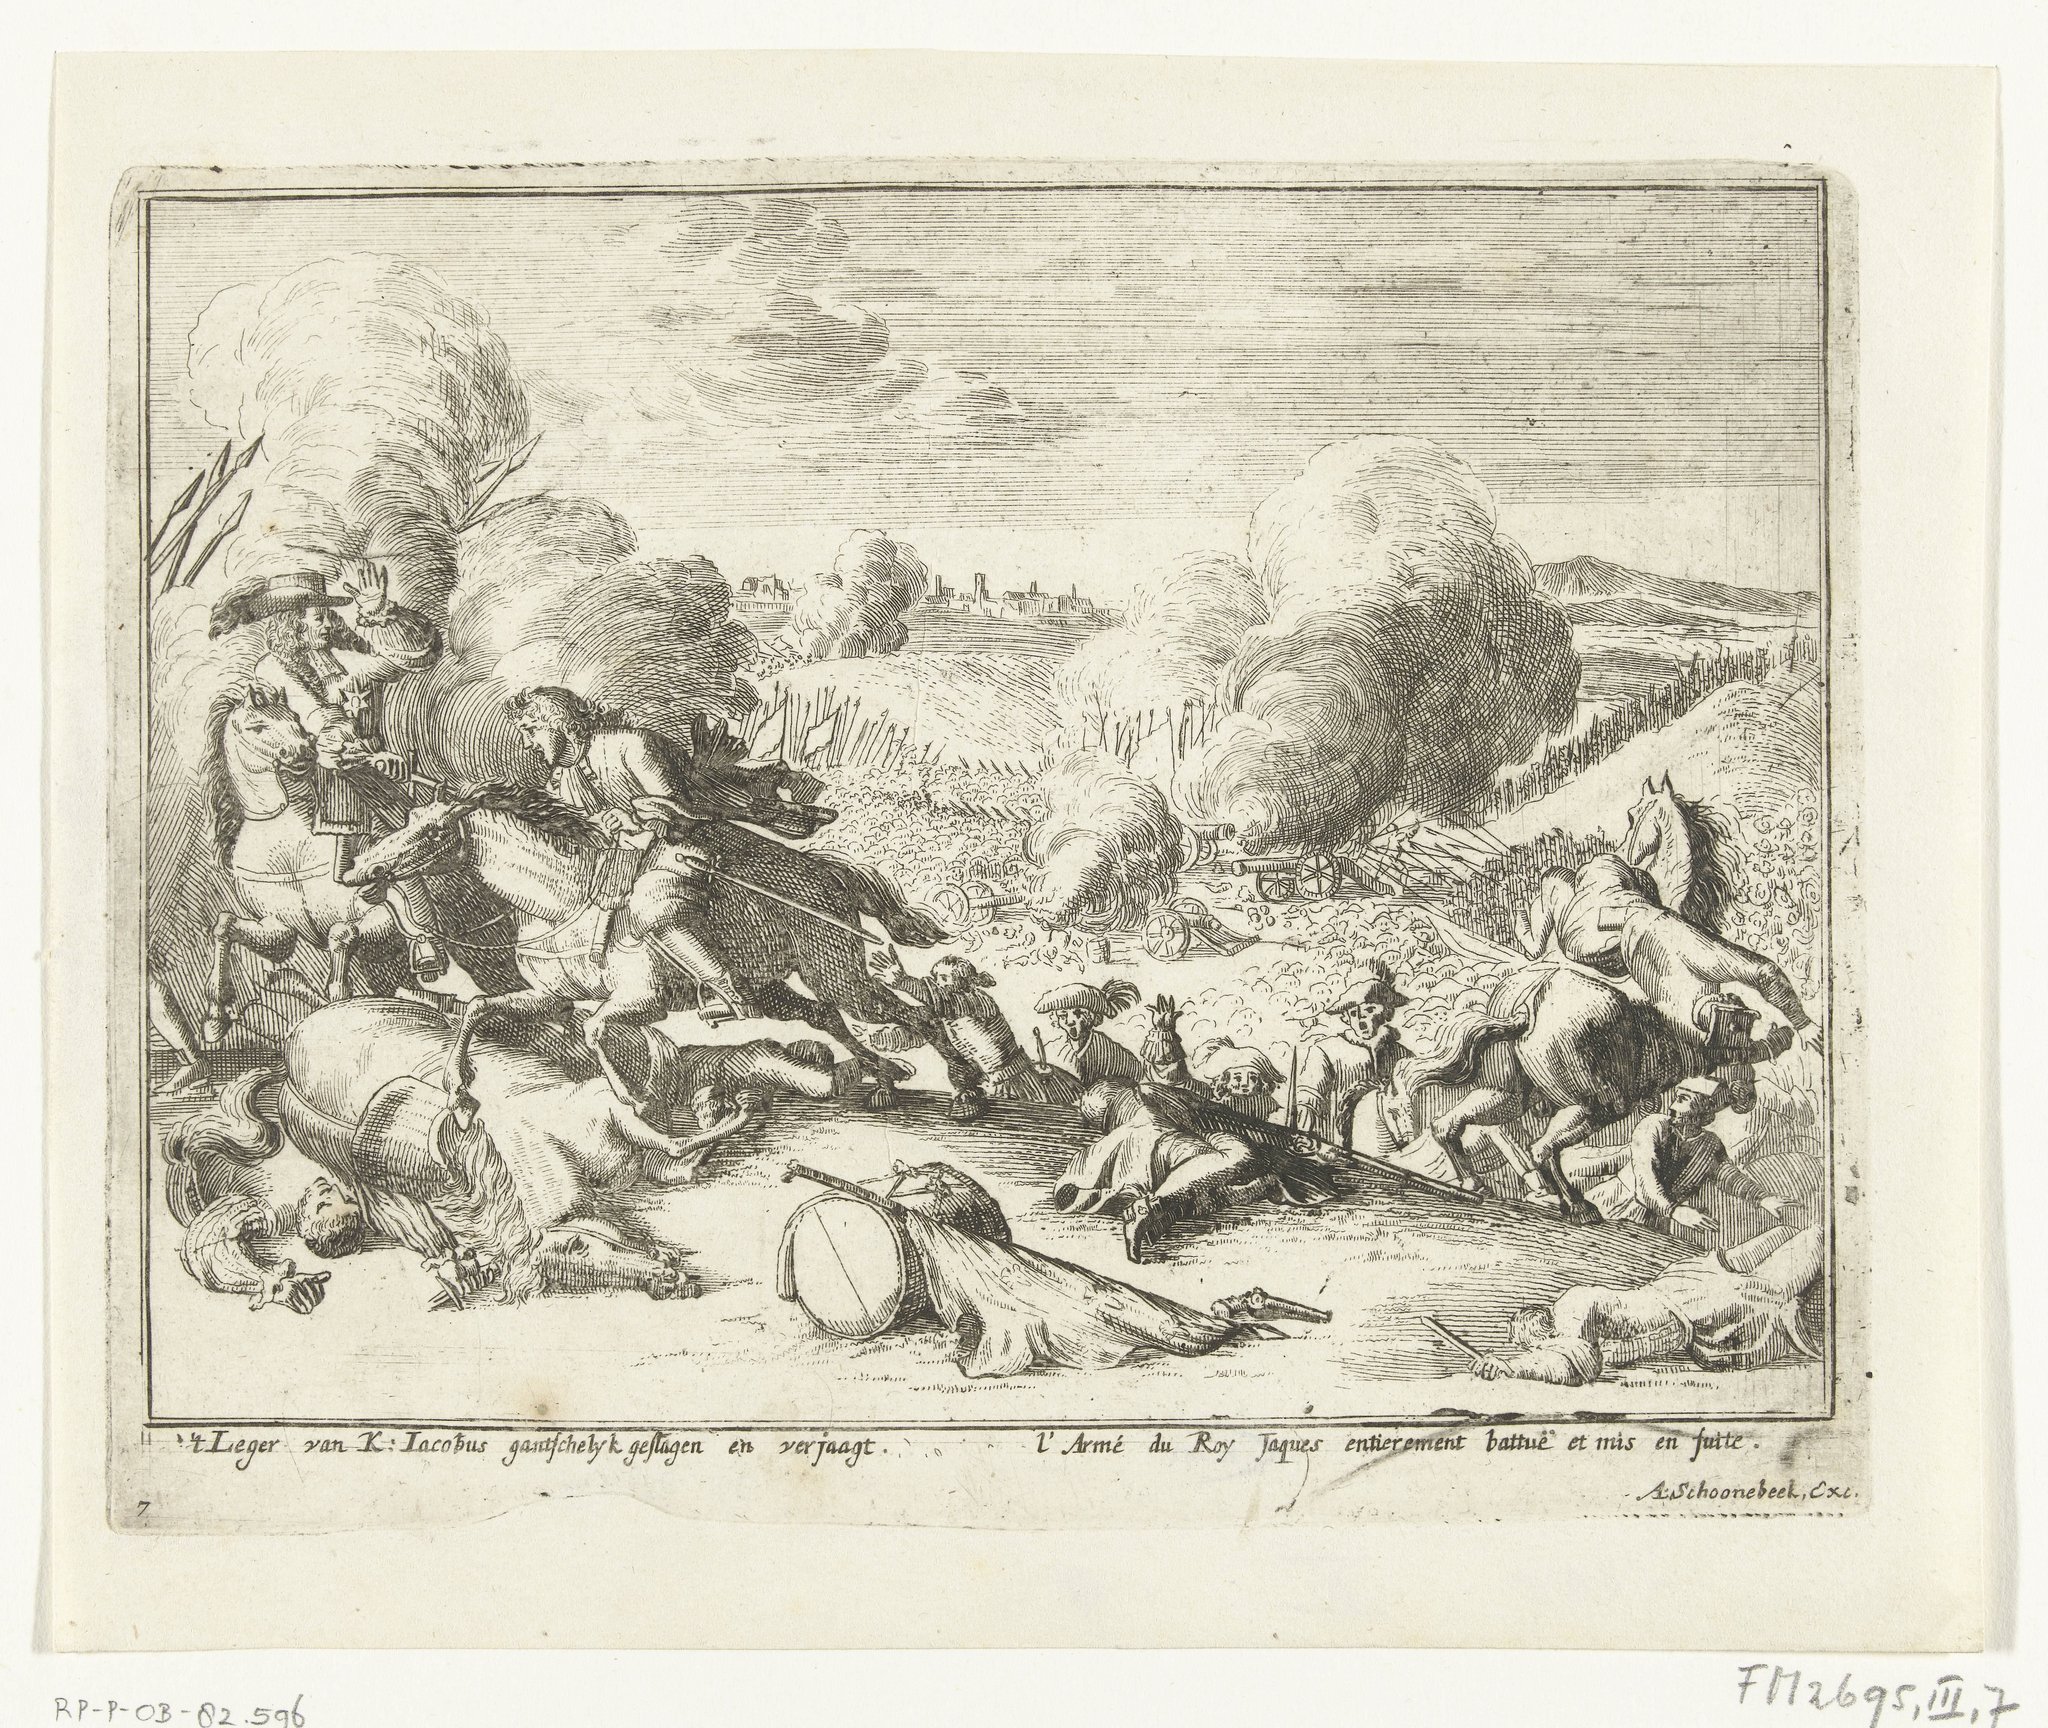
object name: print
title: Engelands schouwtoneel verbeeldende de voornaamste voorvallen in Yrland van 't Jaar 1690 tot de velttogt van S:K: Mayesteit van Groot Brittanie 1691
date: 1691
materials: paper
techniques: etching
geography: amsterdam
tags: jacobus ii (koning van engeland en schotland), battle (+ land forces)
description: Het leger van Jacobus II verslagen en verjaagd in de slag bij de Boyne, 11 juli 1690. Plaat nr. 7 in de serie 'Engelands schouwtoneel' over de oorlog tussen Willem III en Jacobus II in de jaren 1690-1691 na de Glorious Revolution, (derde deel). Met onderschriften in het Nederlands en Frans.